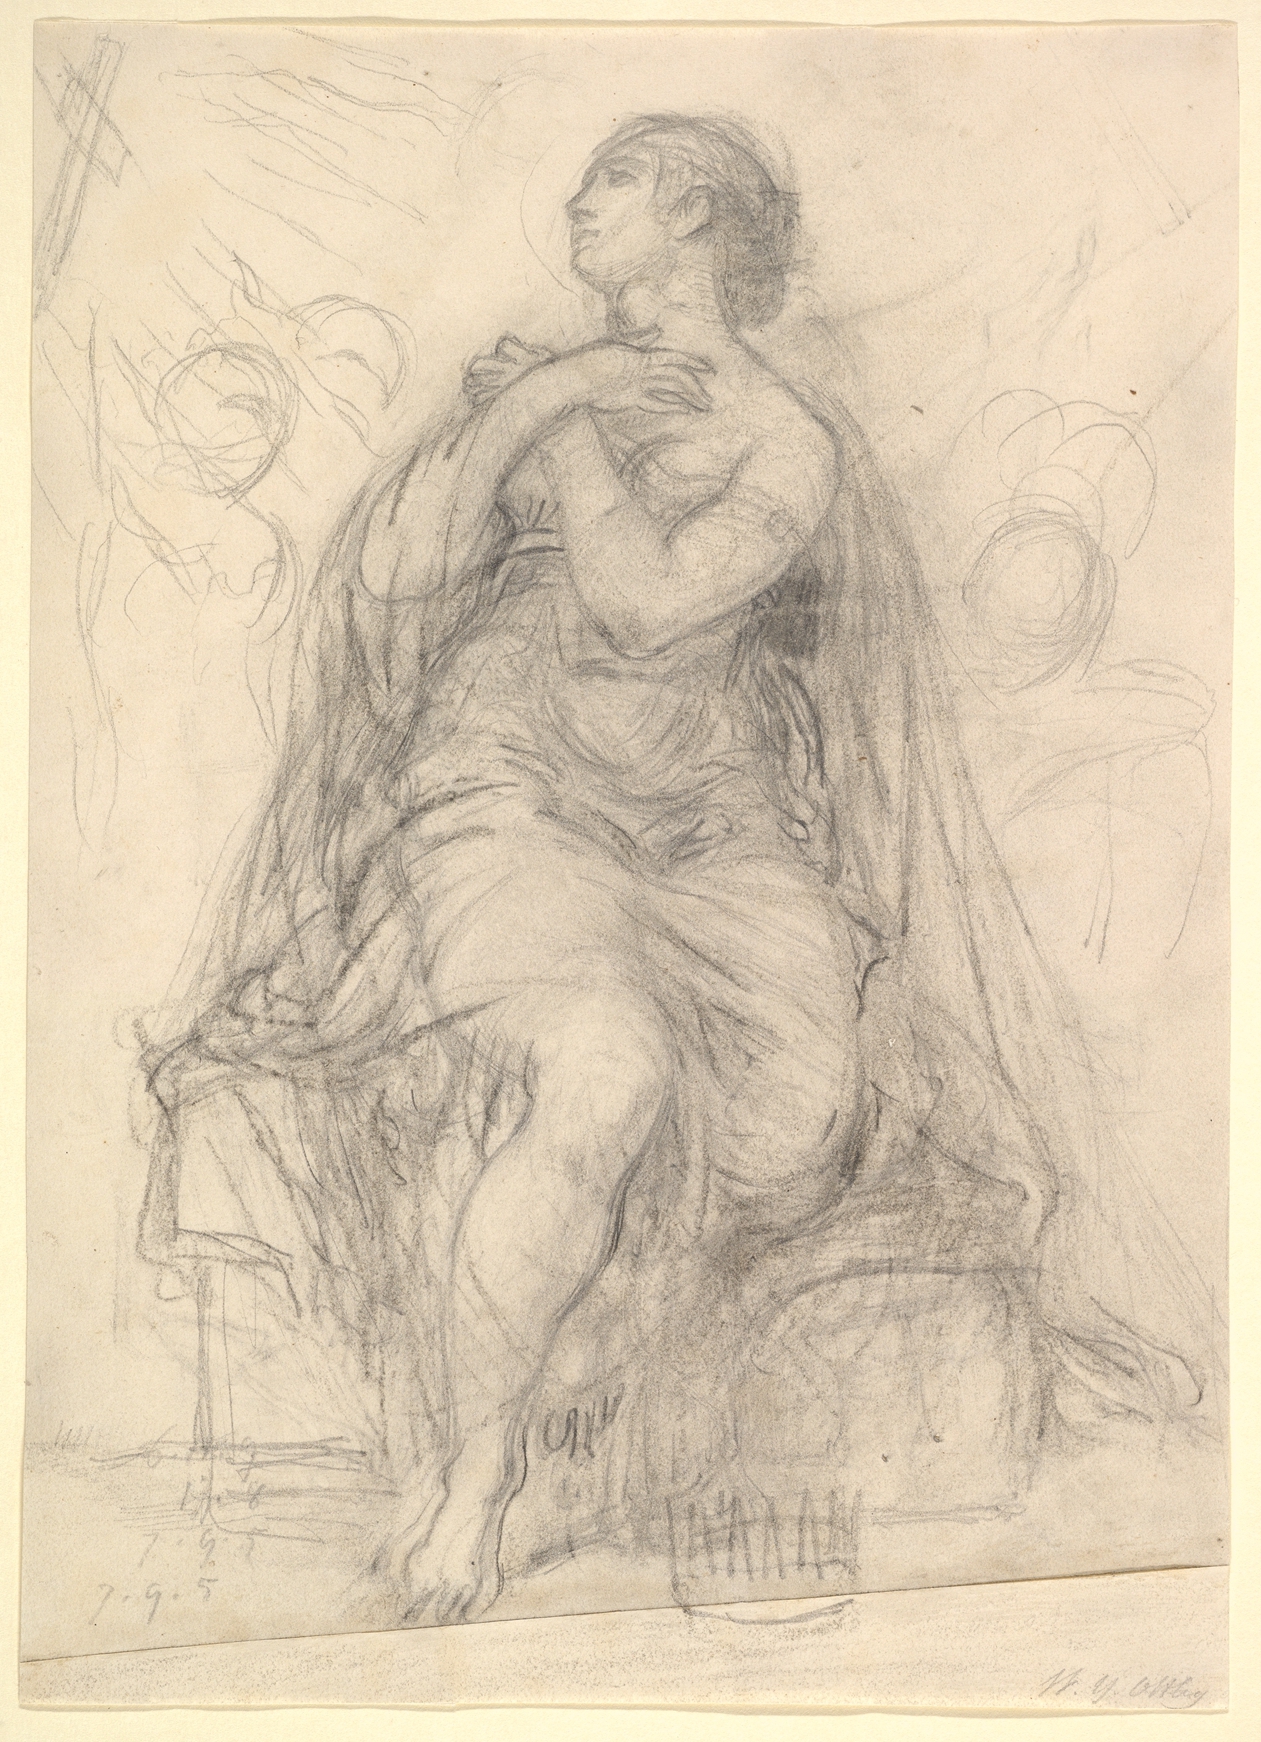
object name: drawing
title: Vision of the True Cross appearing to St. Helen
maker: william young ottley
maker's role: artist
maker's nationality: british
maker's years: 1771-1836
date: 1795-1836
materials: chalk, graphite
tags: women,cross,saints